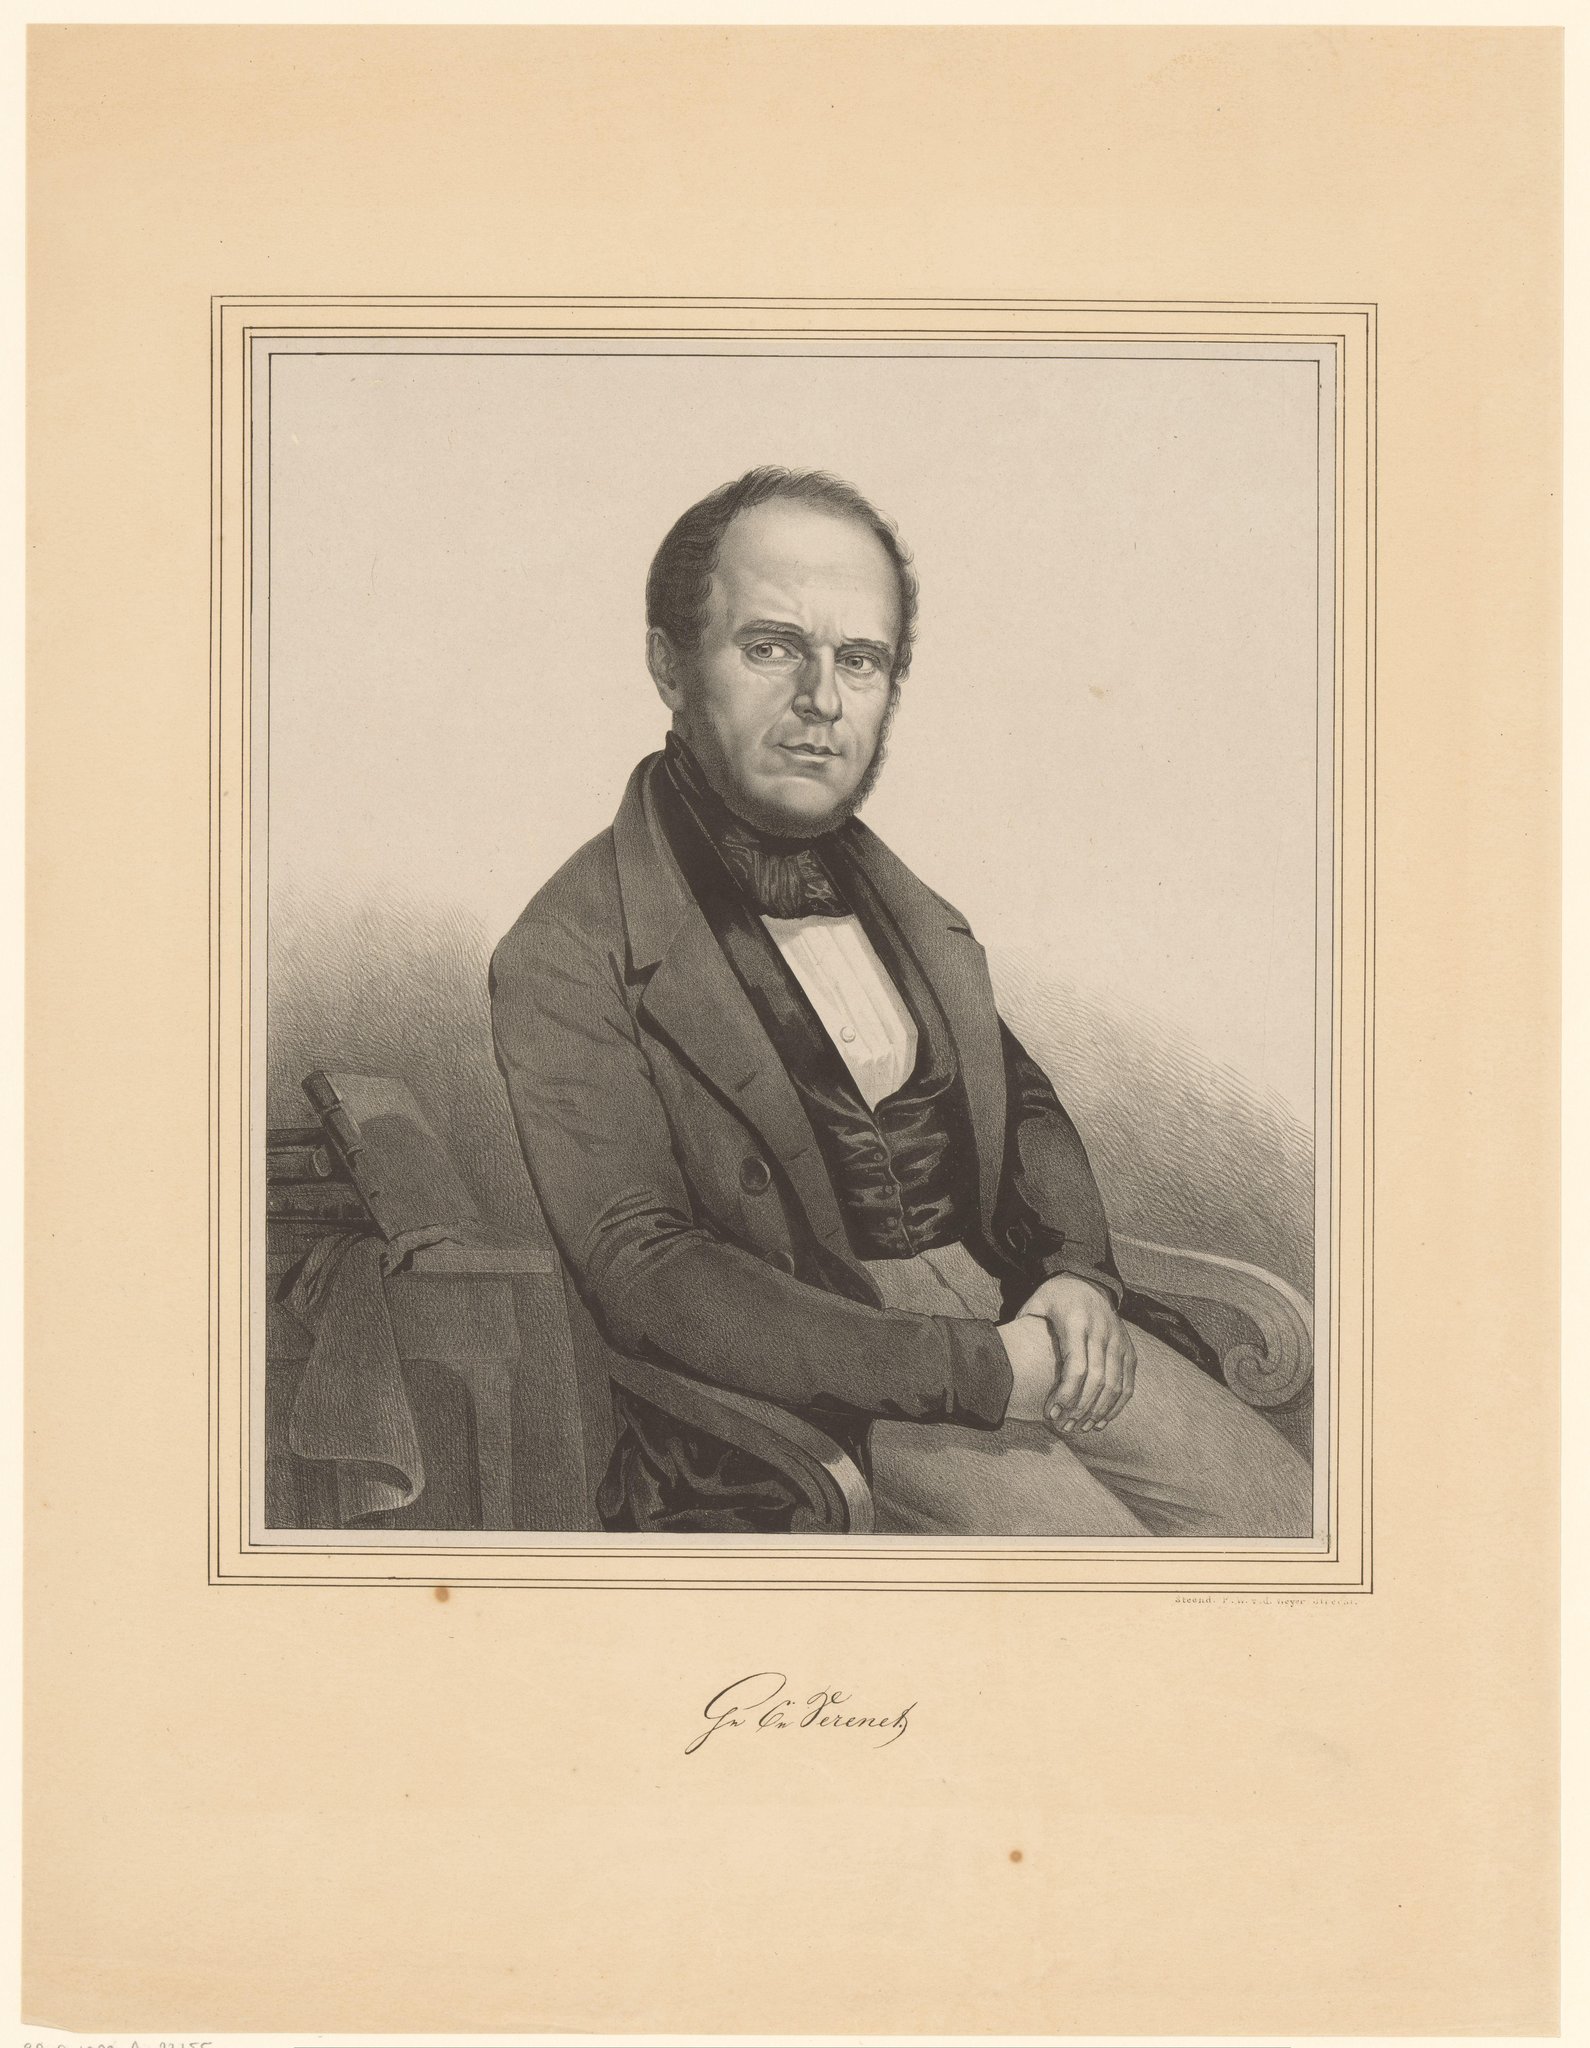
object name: print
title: Portret van G.C. Verenet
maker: pieter wilhelmus van de weijer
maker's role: print maker, printer, publisher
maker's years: 1816-1880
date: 1842-1880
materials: paper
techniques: lithograph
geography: utrecht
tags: historical persons (+ half-length portrait)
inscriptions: collector's mark: Lugt 2228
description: Onder het portret de signatuur van de geportretteerde.